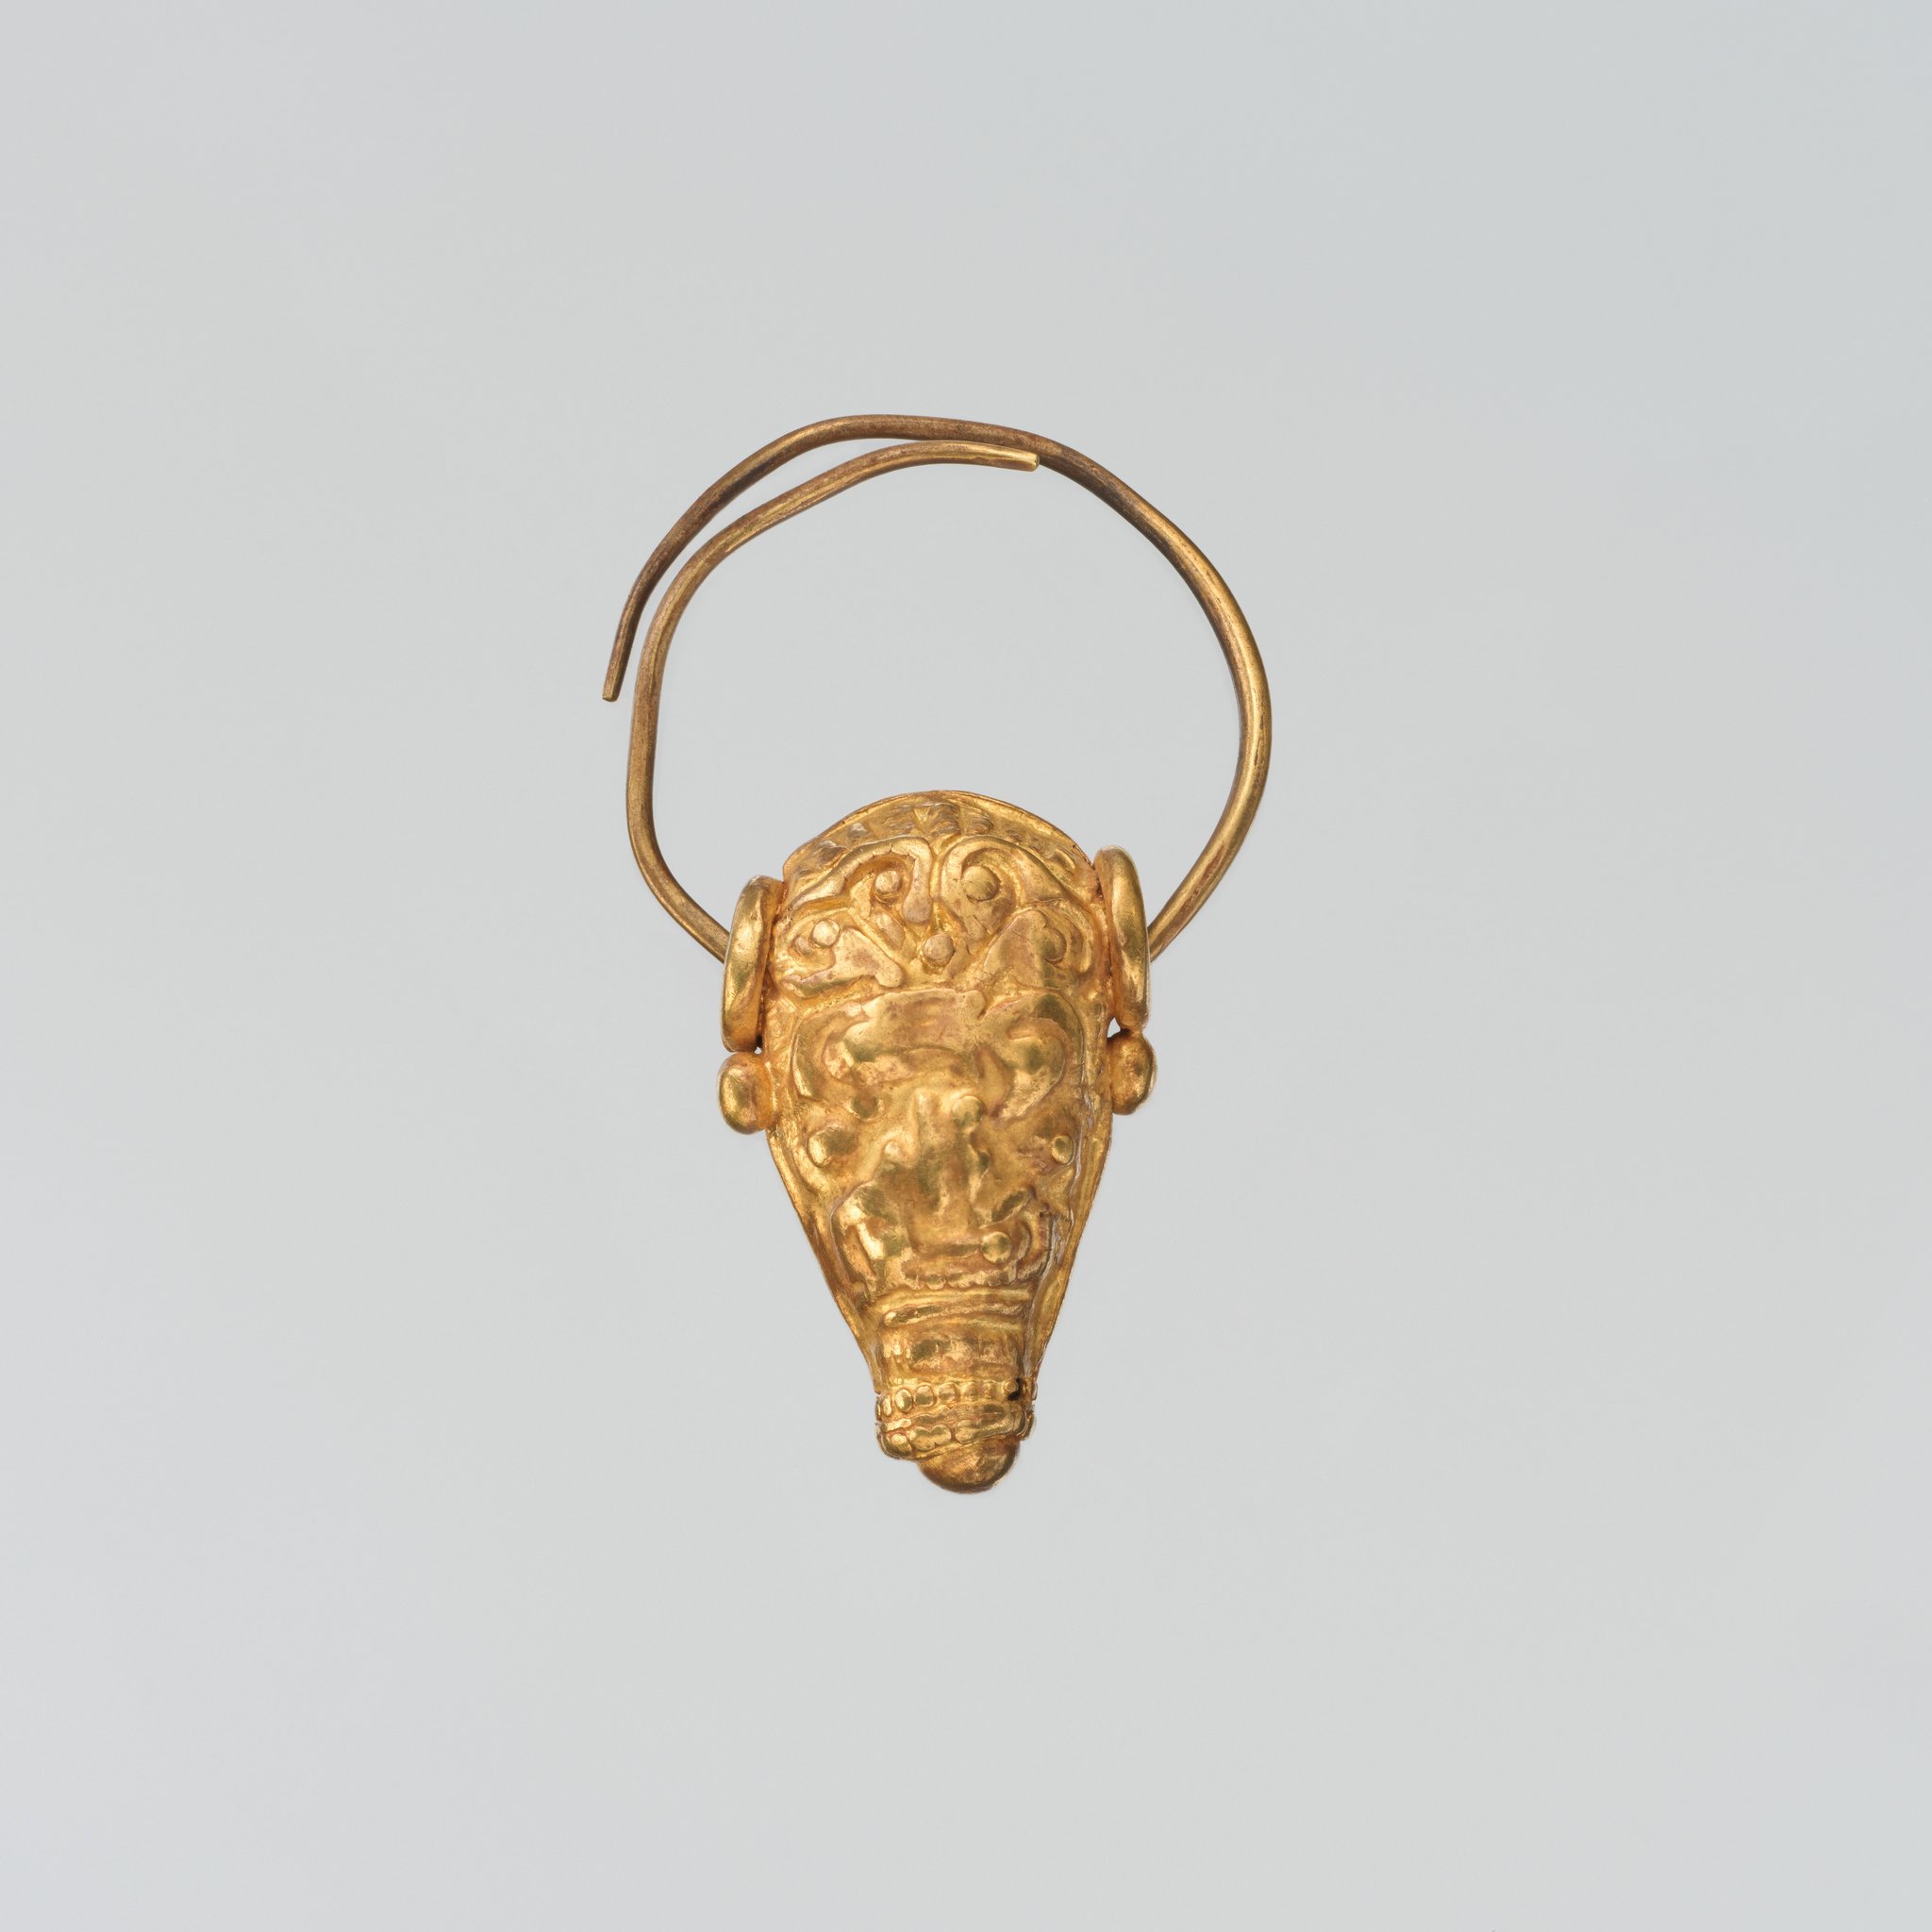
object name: earring with head of bull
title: Gold earring with head of a bull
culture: cypriot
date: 1400-1050 BCE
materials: gold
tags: bulls